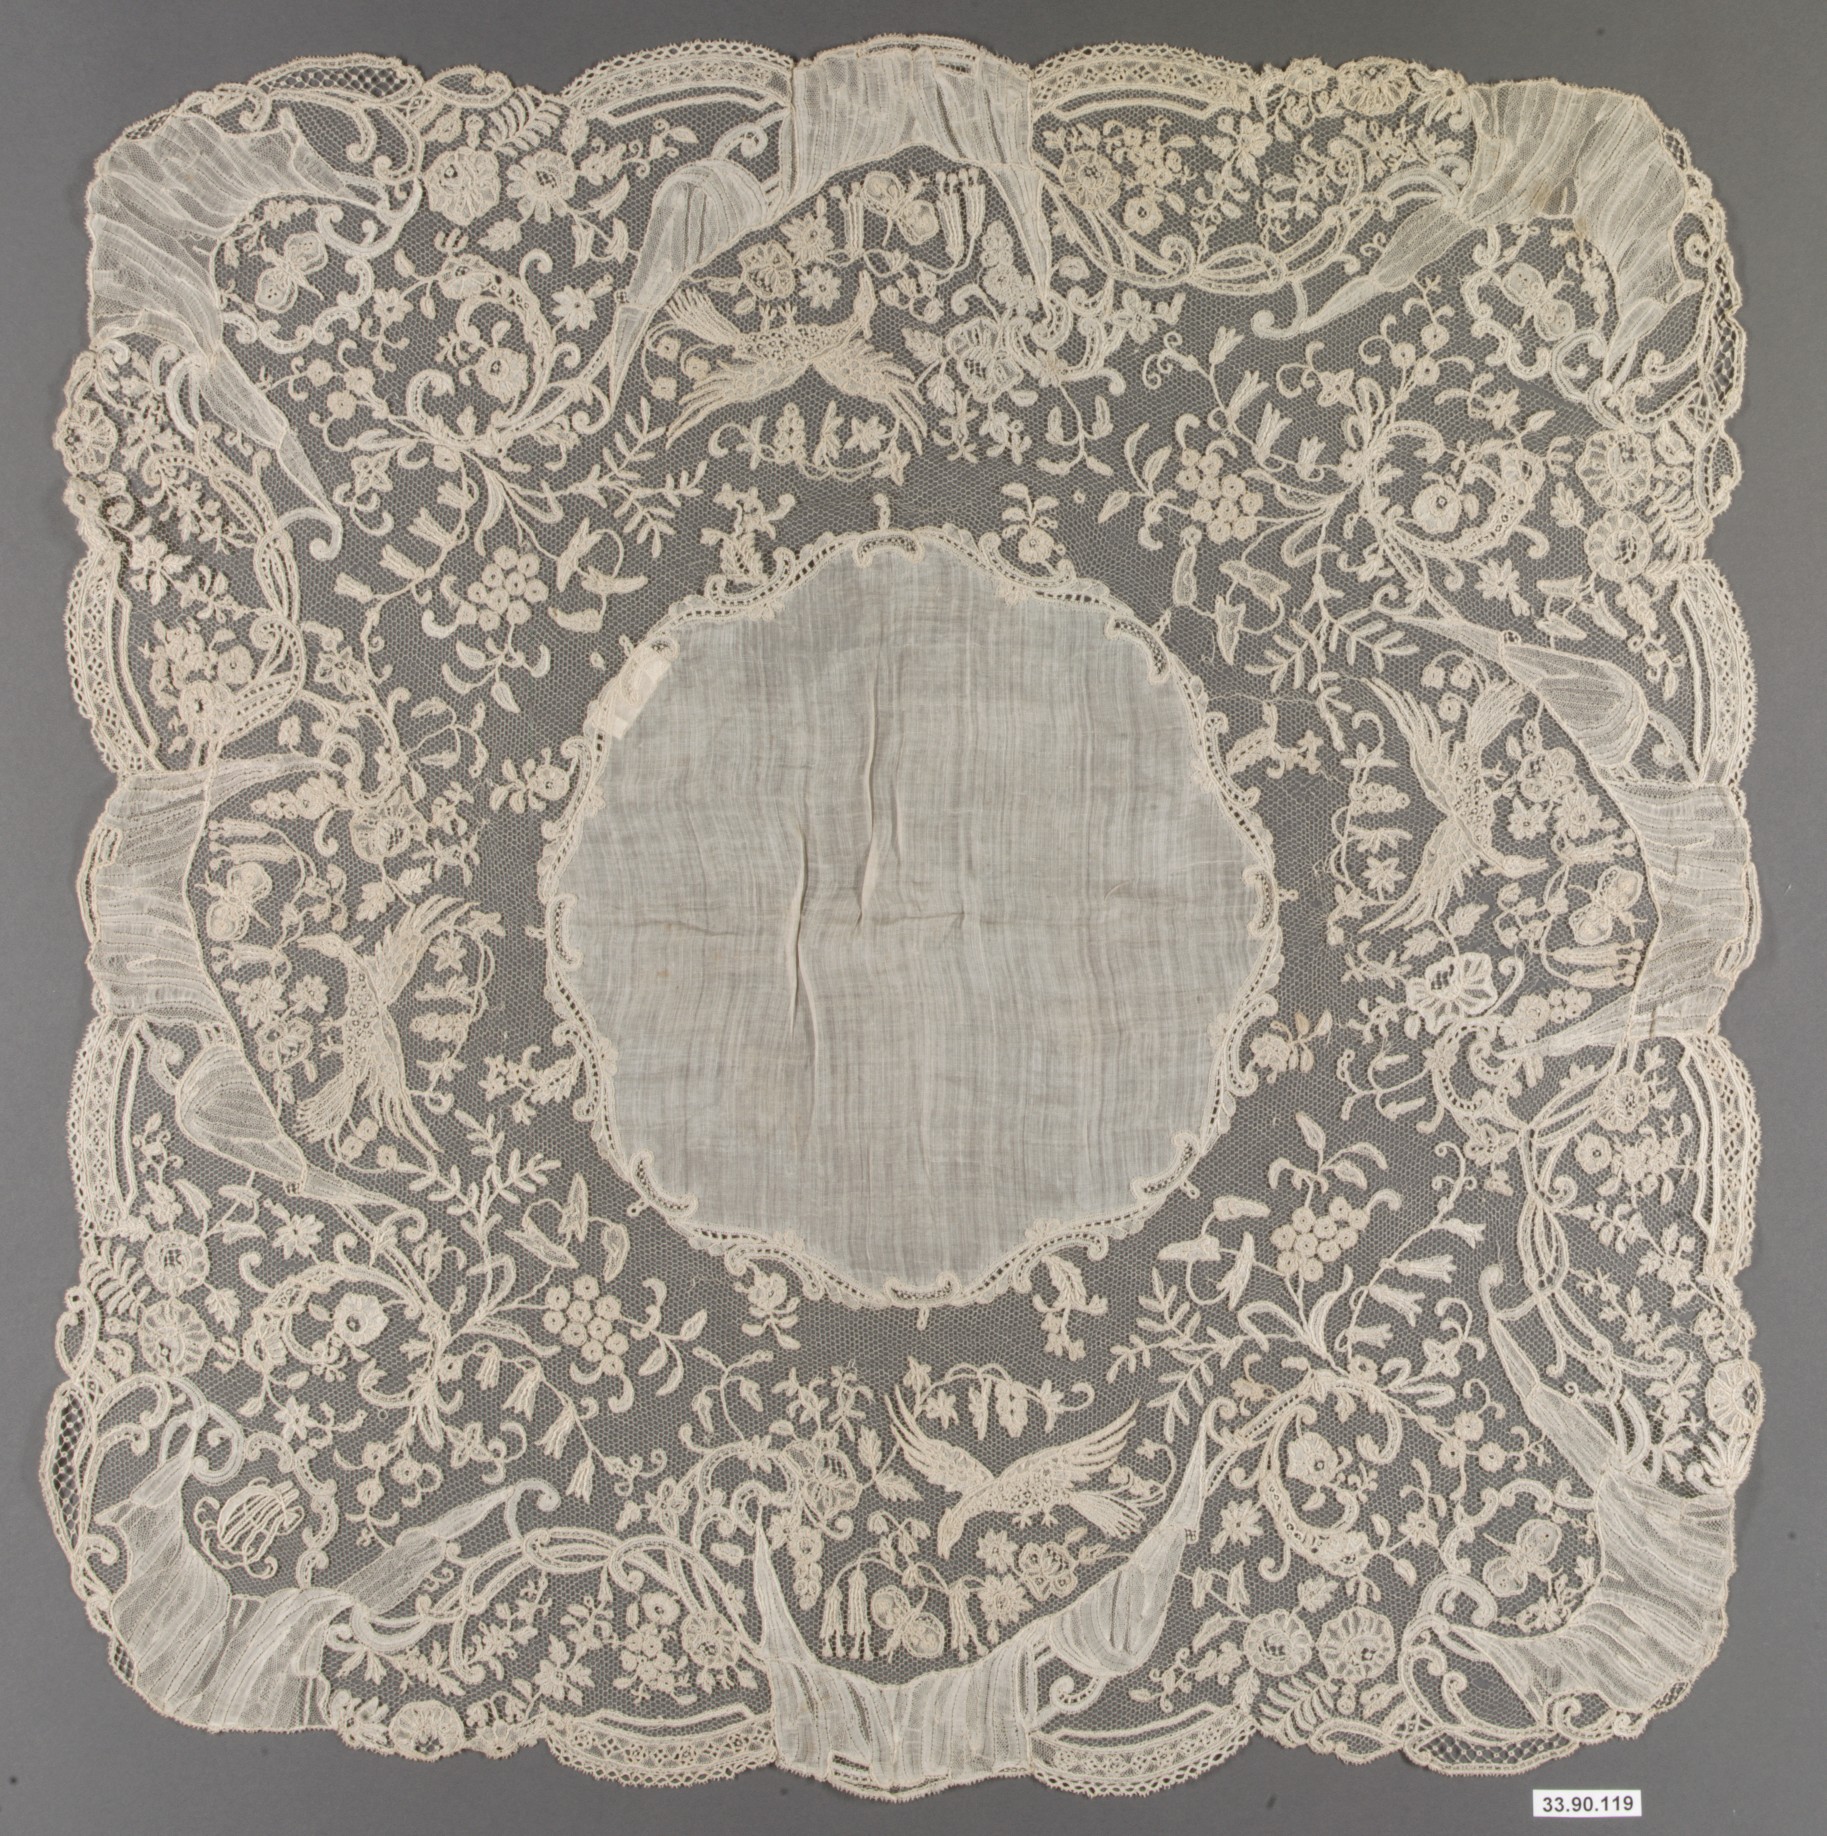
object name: handkerchief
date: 1851-1875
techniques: lace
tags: birds,flowers